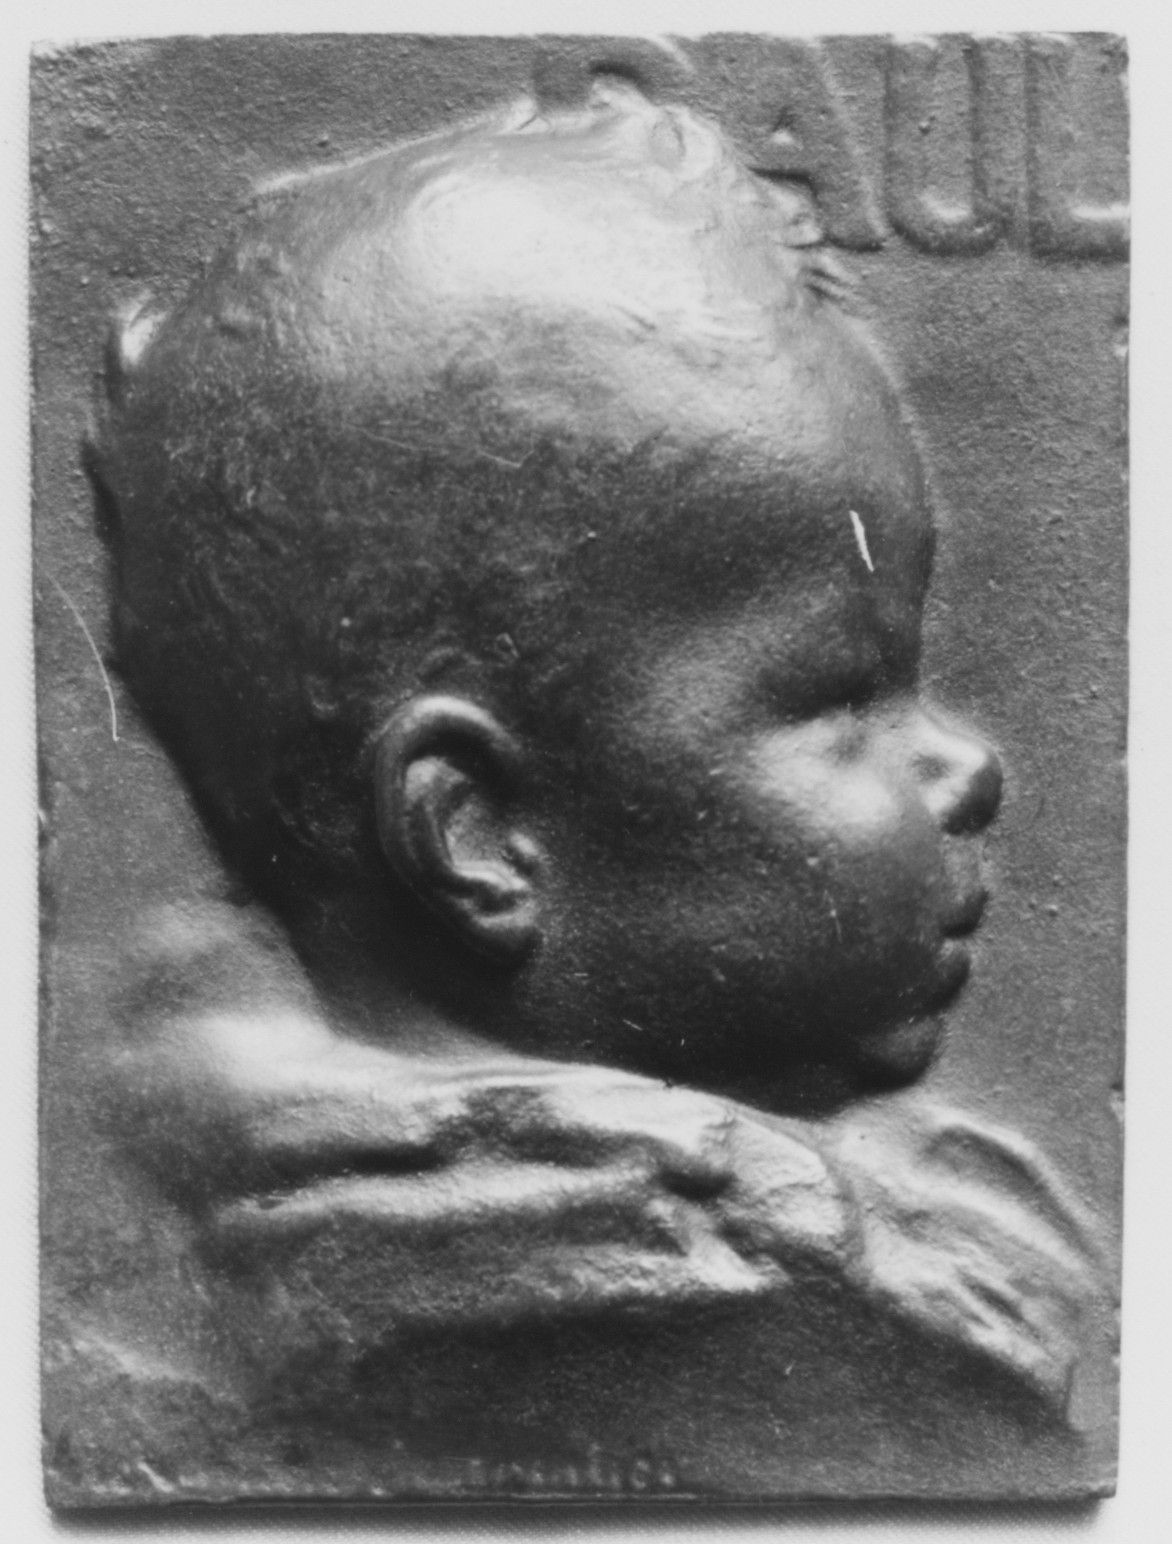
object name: plaquette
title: Portrait of Infant (Paul Fierens)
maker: alexandre-louis-marie charpentier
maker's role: artist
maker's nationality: french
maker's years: 1856-1909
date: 1867-1900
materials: bronze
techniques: casting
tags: infants,profiles